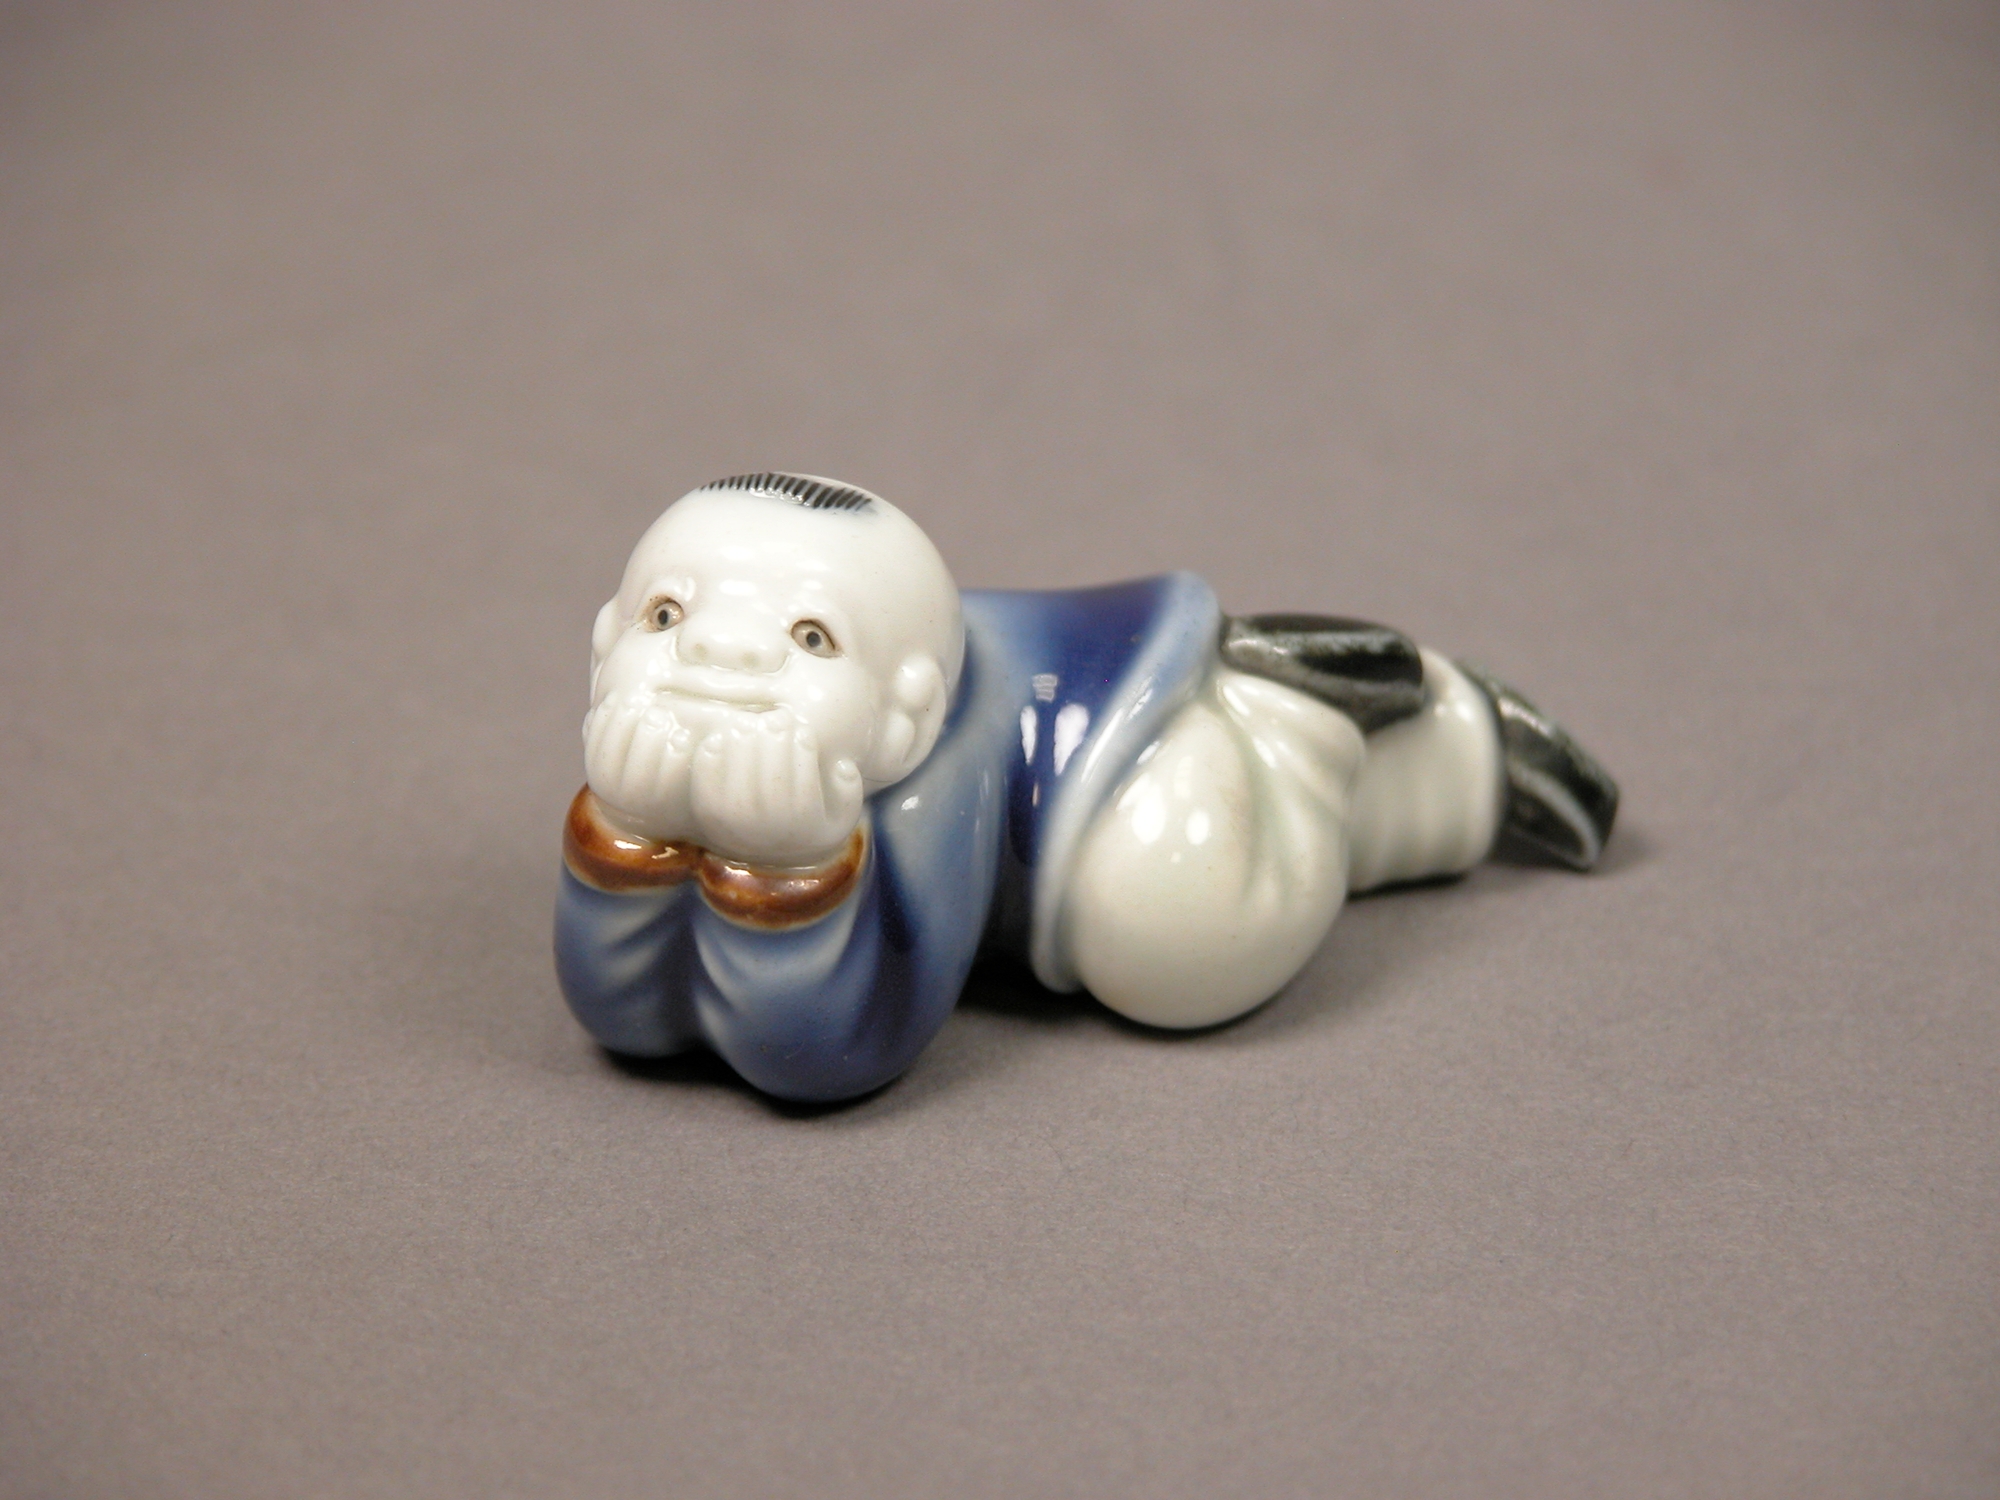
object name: figure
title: Child Lying Down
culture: japanese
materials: enamel, porcelain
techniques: overglaze, underglaze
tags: boys